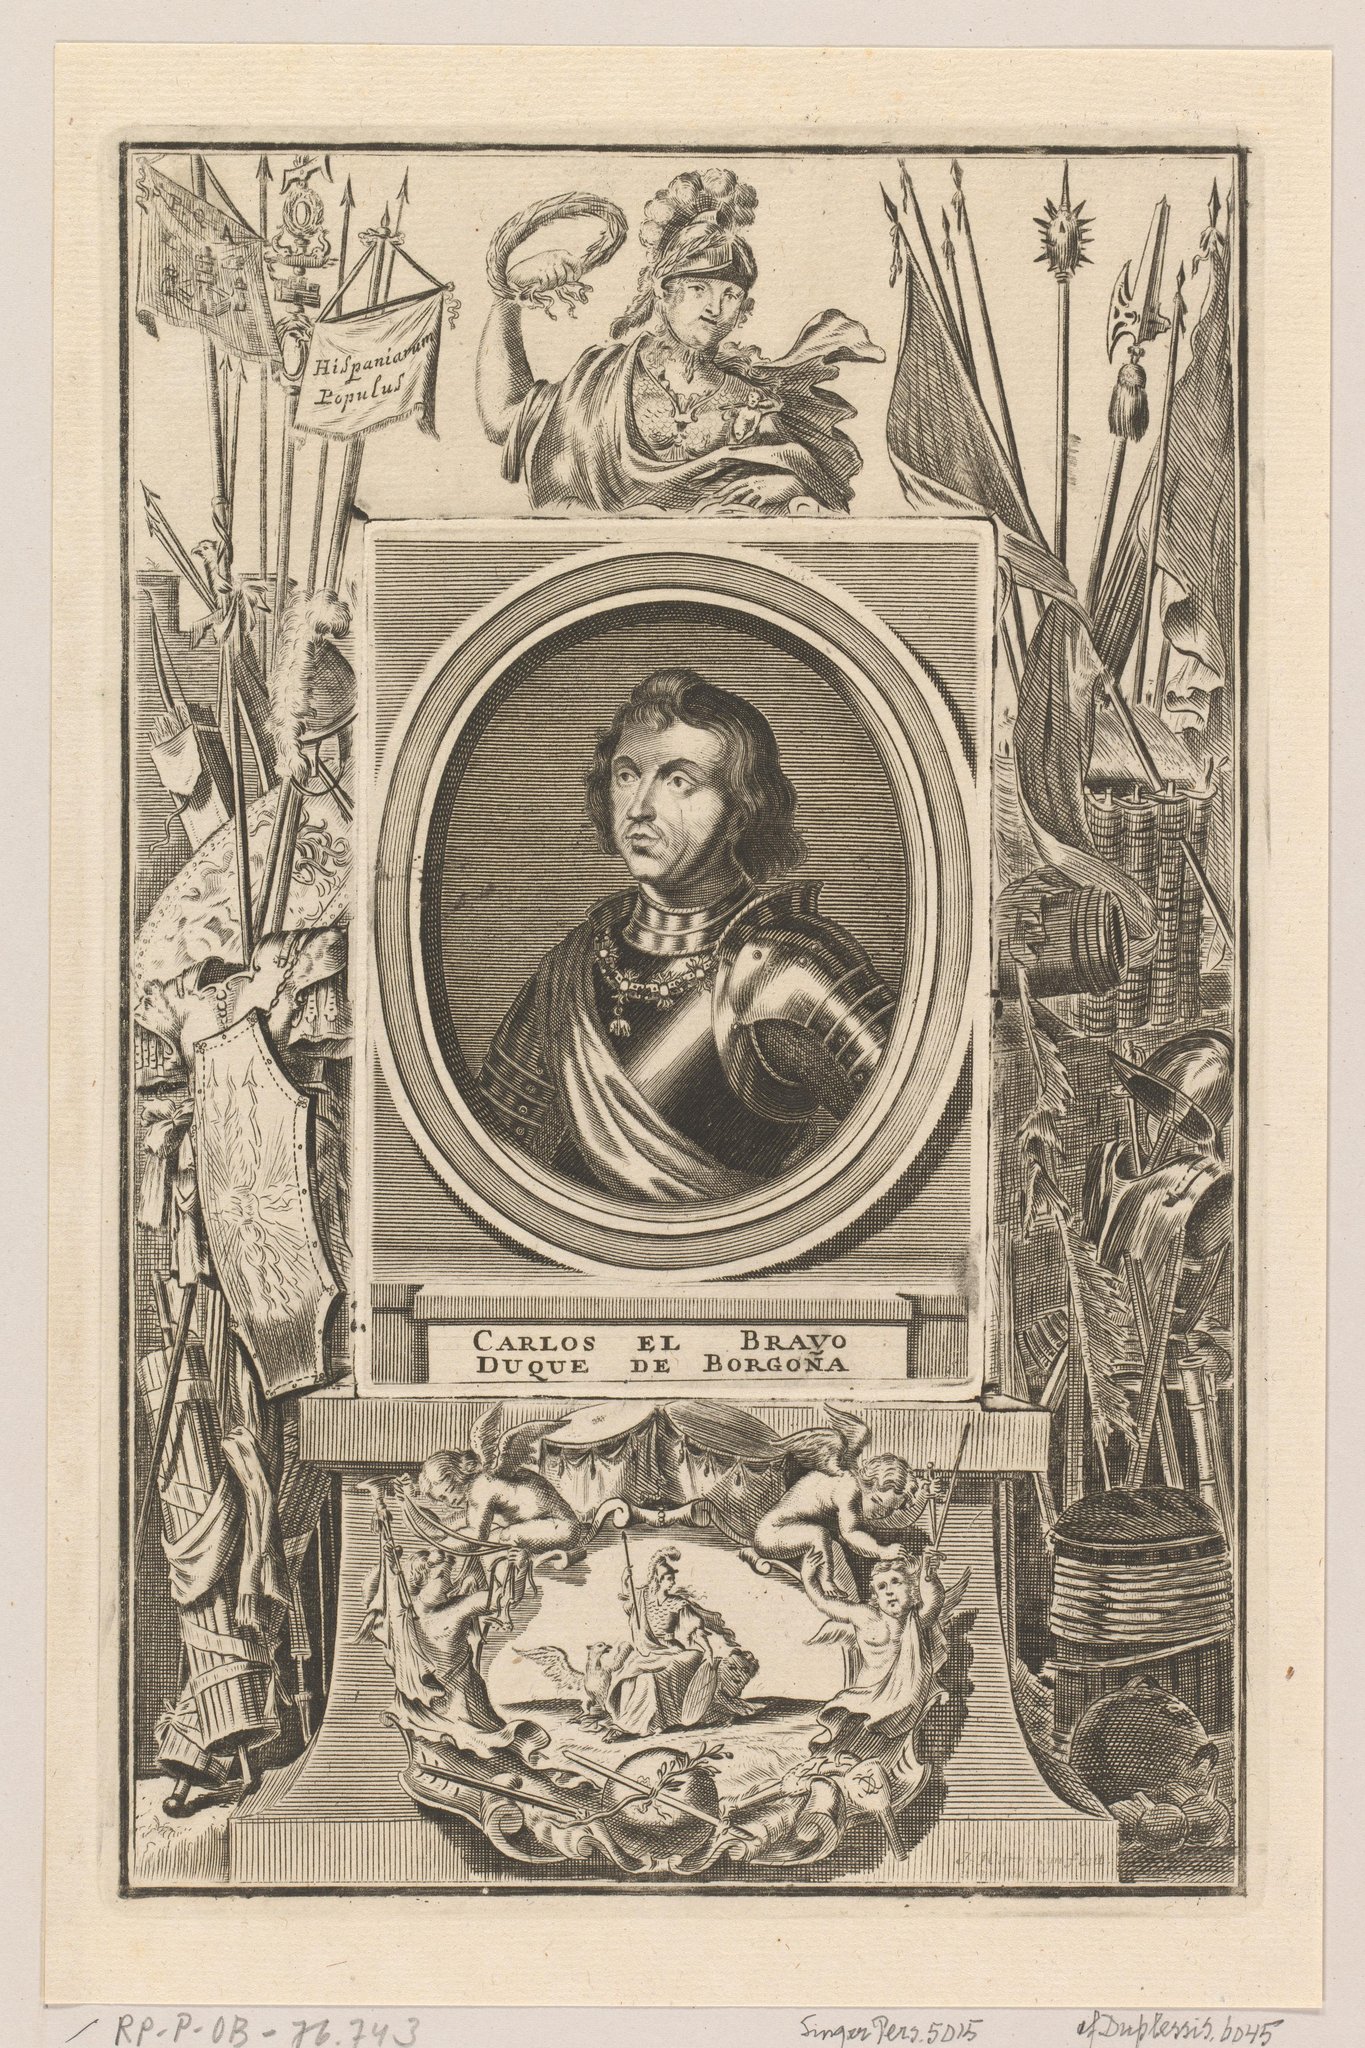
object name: print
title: Portret van Karel de Stoute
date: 1713-1714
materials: paper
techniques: engraving, etching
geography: low countries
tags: charles the bold (duke of burgundy), historical persons, ruler, sovereign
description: Prent waarschijnlijk uit: Komen, Filips van. Las Memorias (...). Antwerpen: Hendrik en Cornelis Verdussen, 1713, dl. 1. Of uit de editie uit 1714.